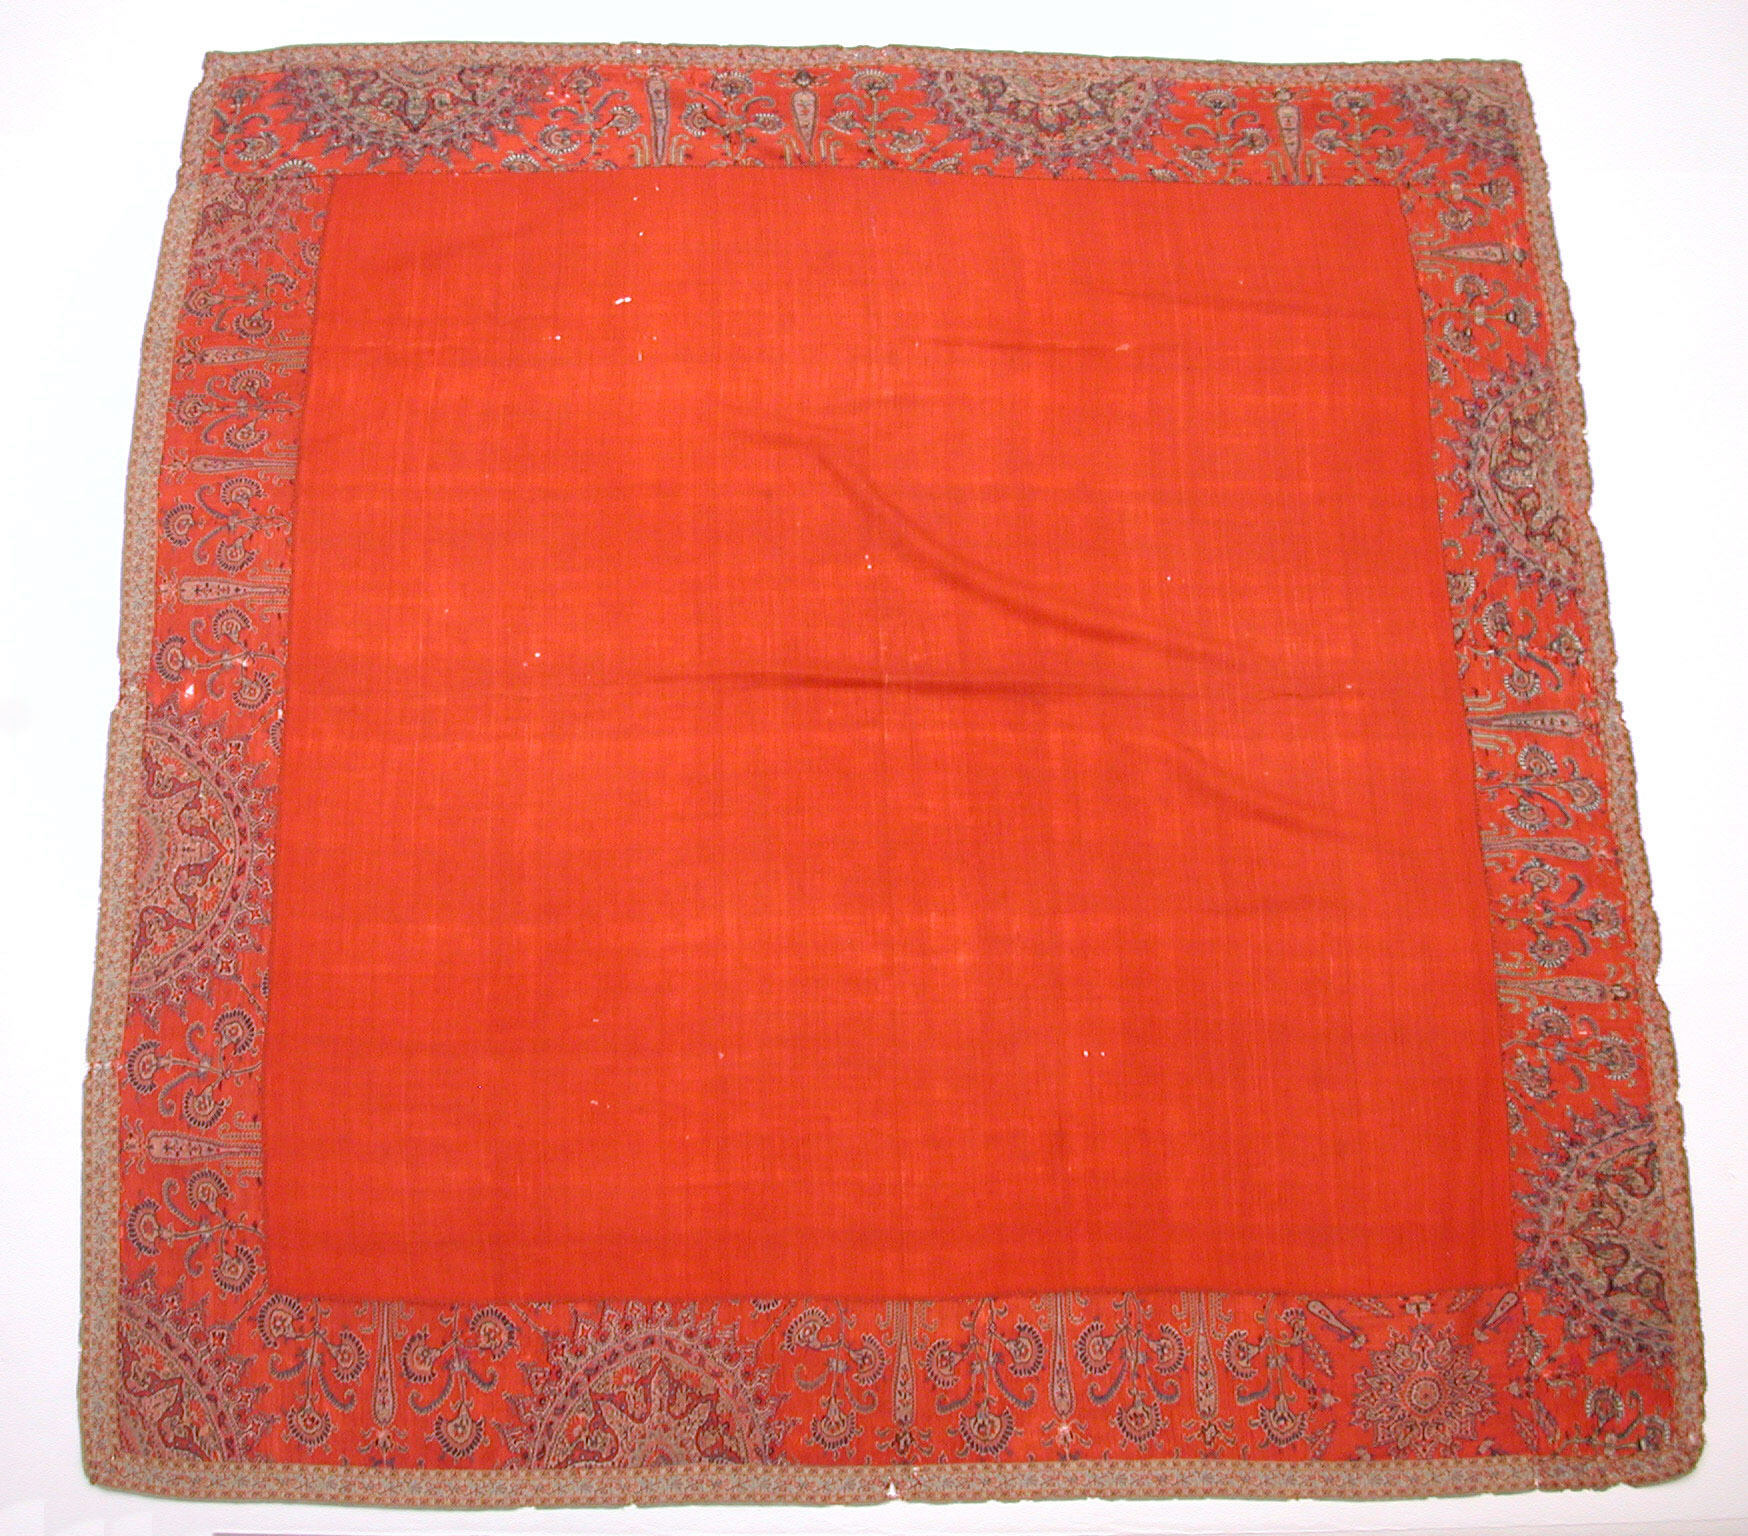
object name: shawl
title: Shawl of Joined Fragments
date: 1825-1835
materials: wool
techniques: weave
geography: india